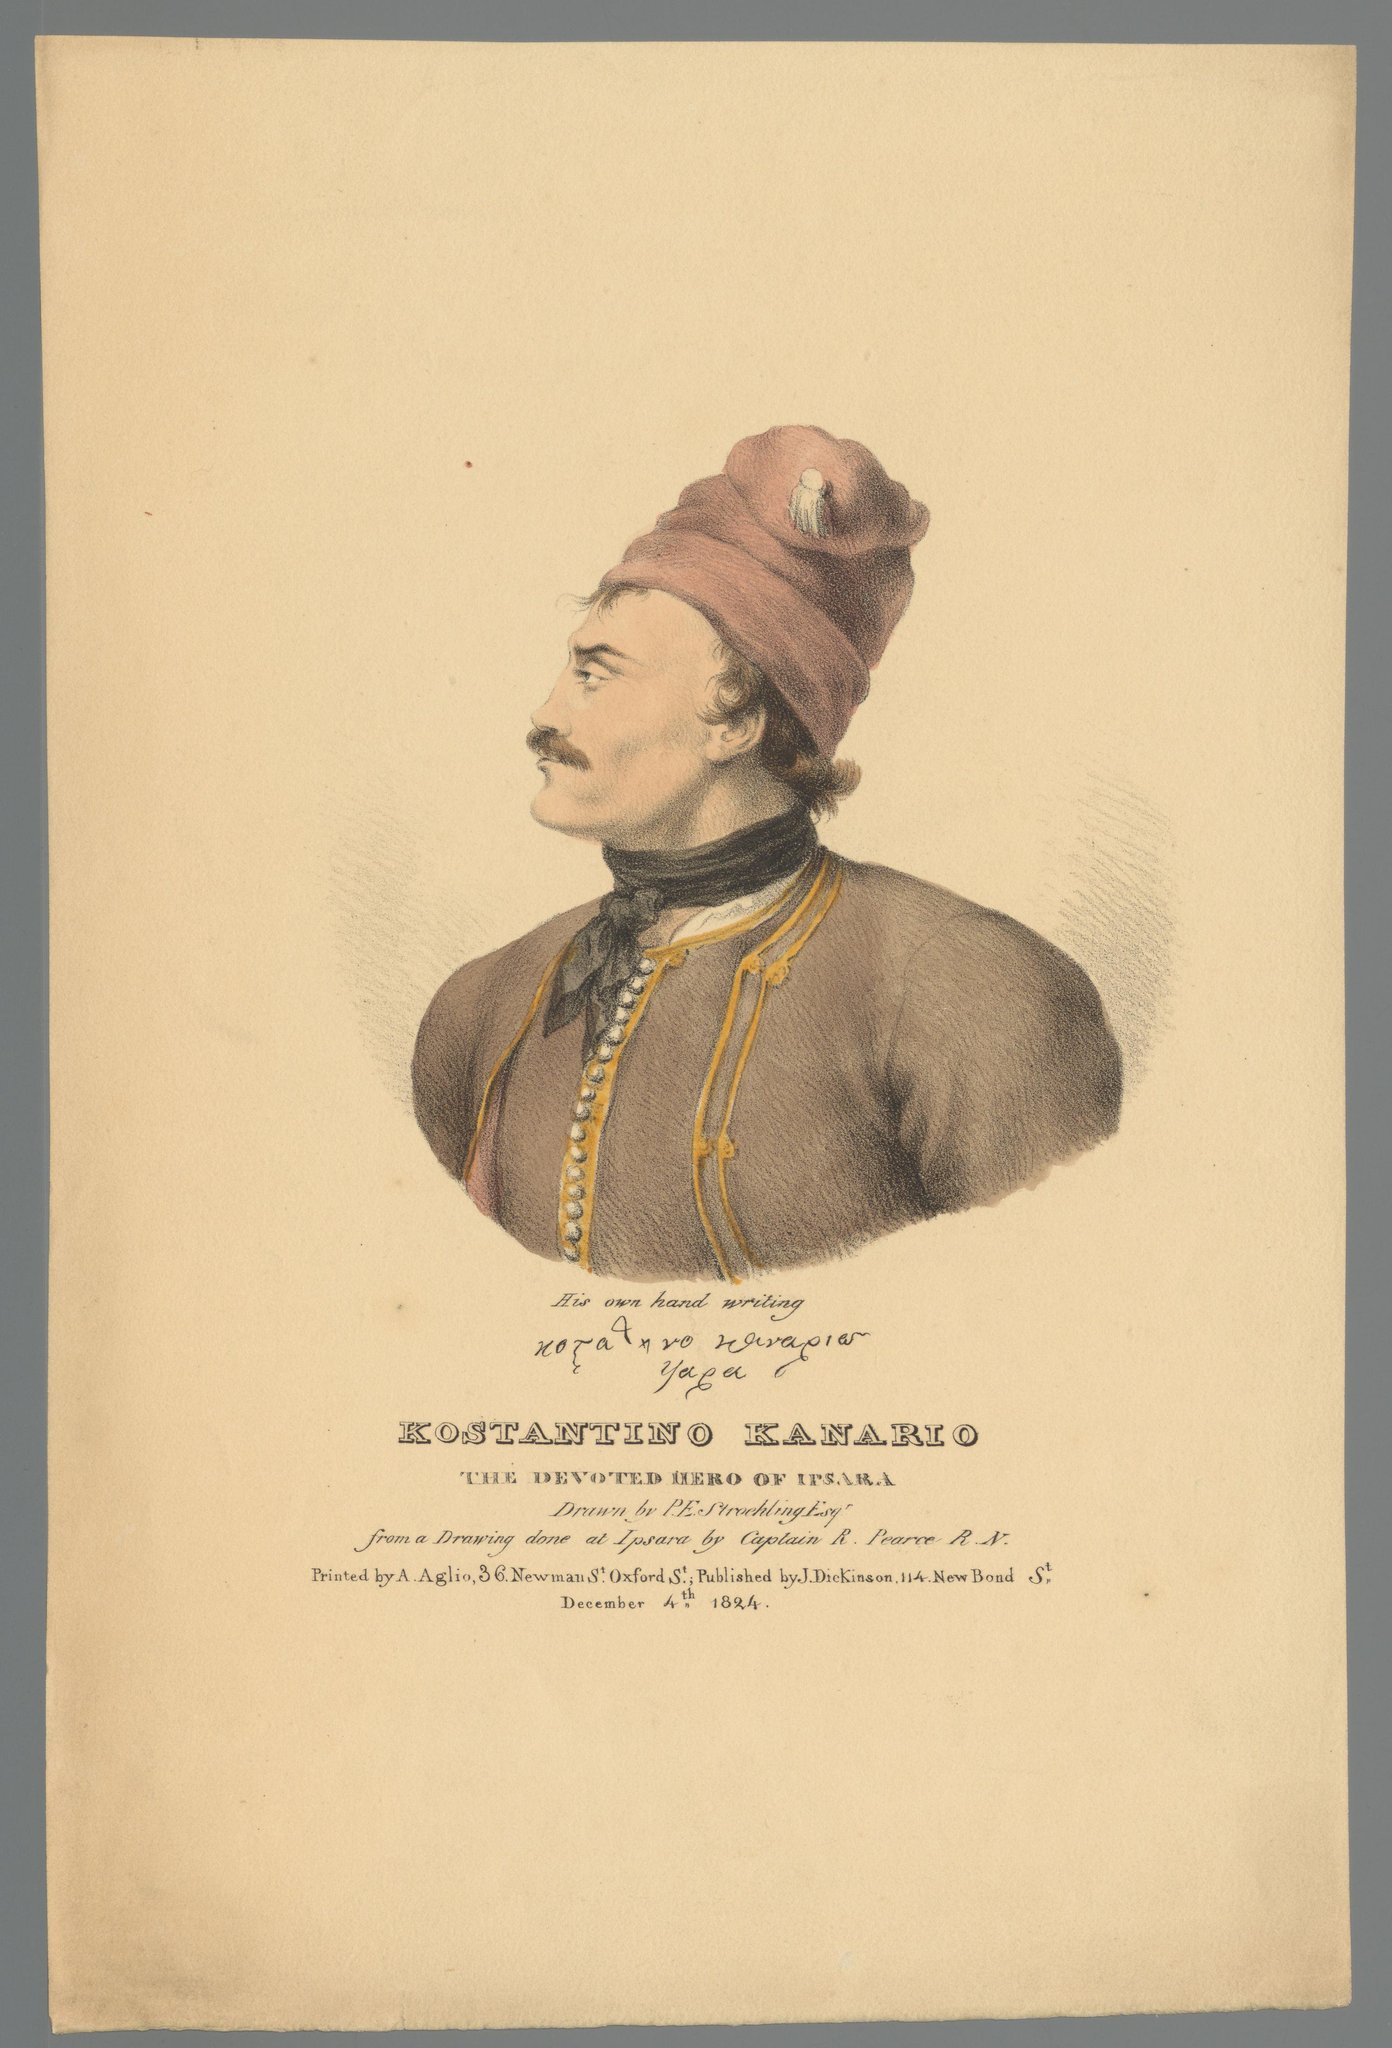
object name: print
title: Portret van Kostantino Kanario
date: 1824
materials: paper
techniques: hand coloring, lithograph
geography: london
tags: moustache, adult man, historical persons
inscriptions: collector's mark: Lugt 2228